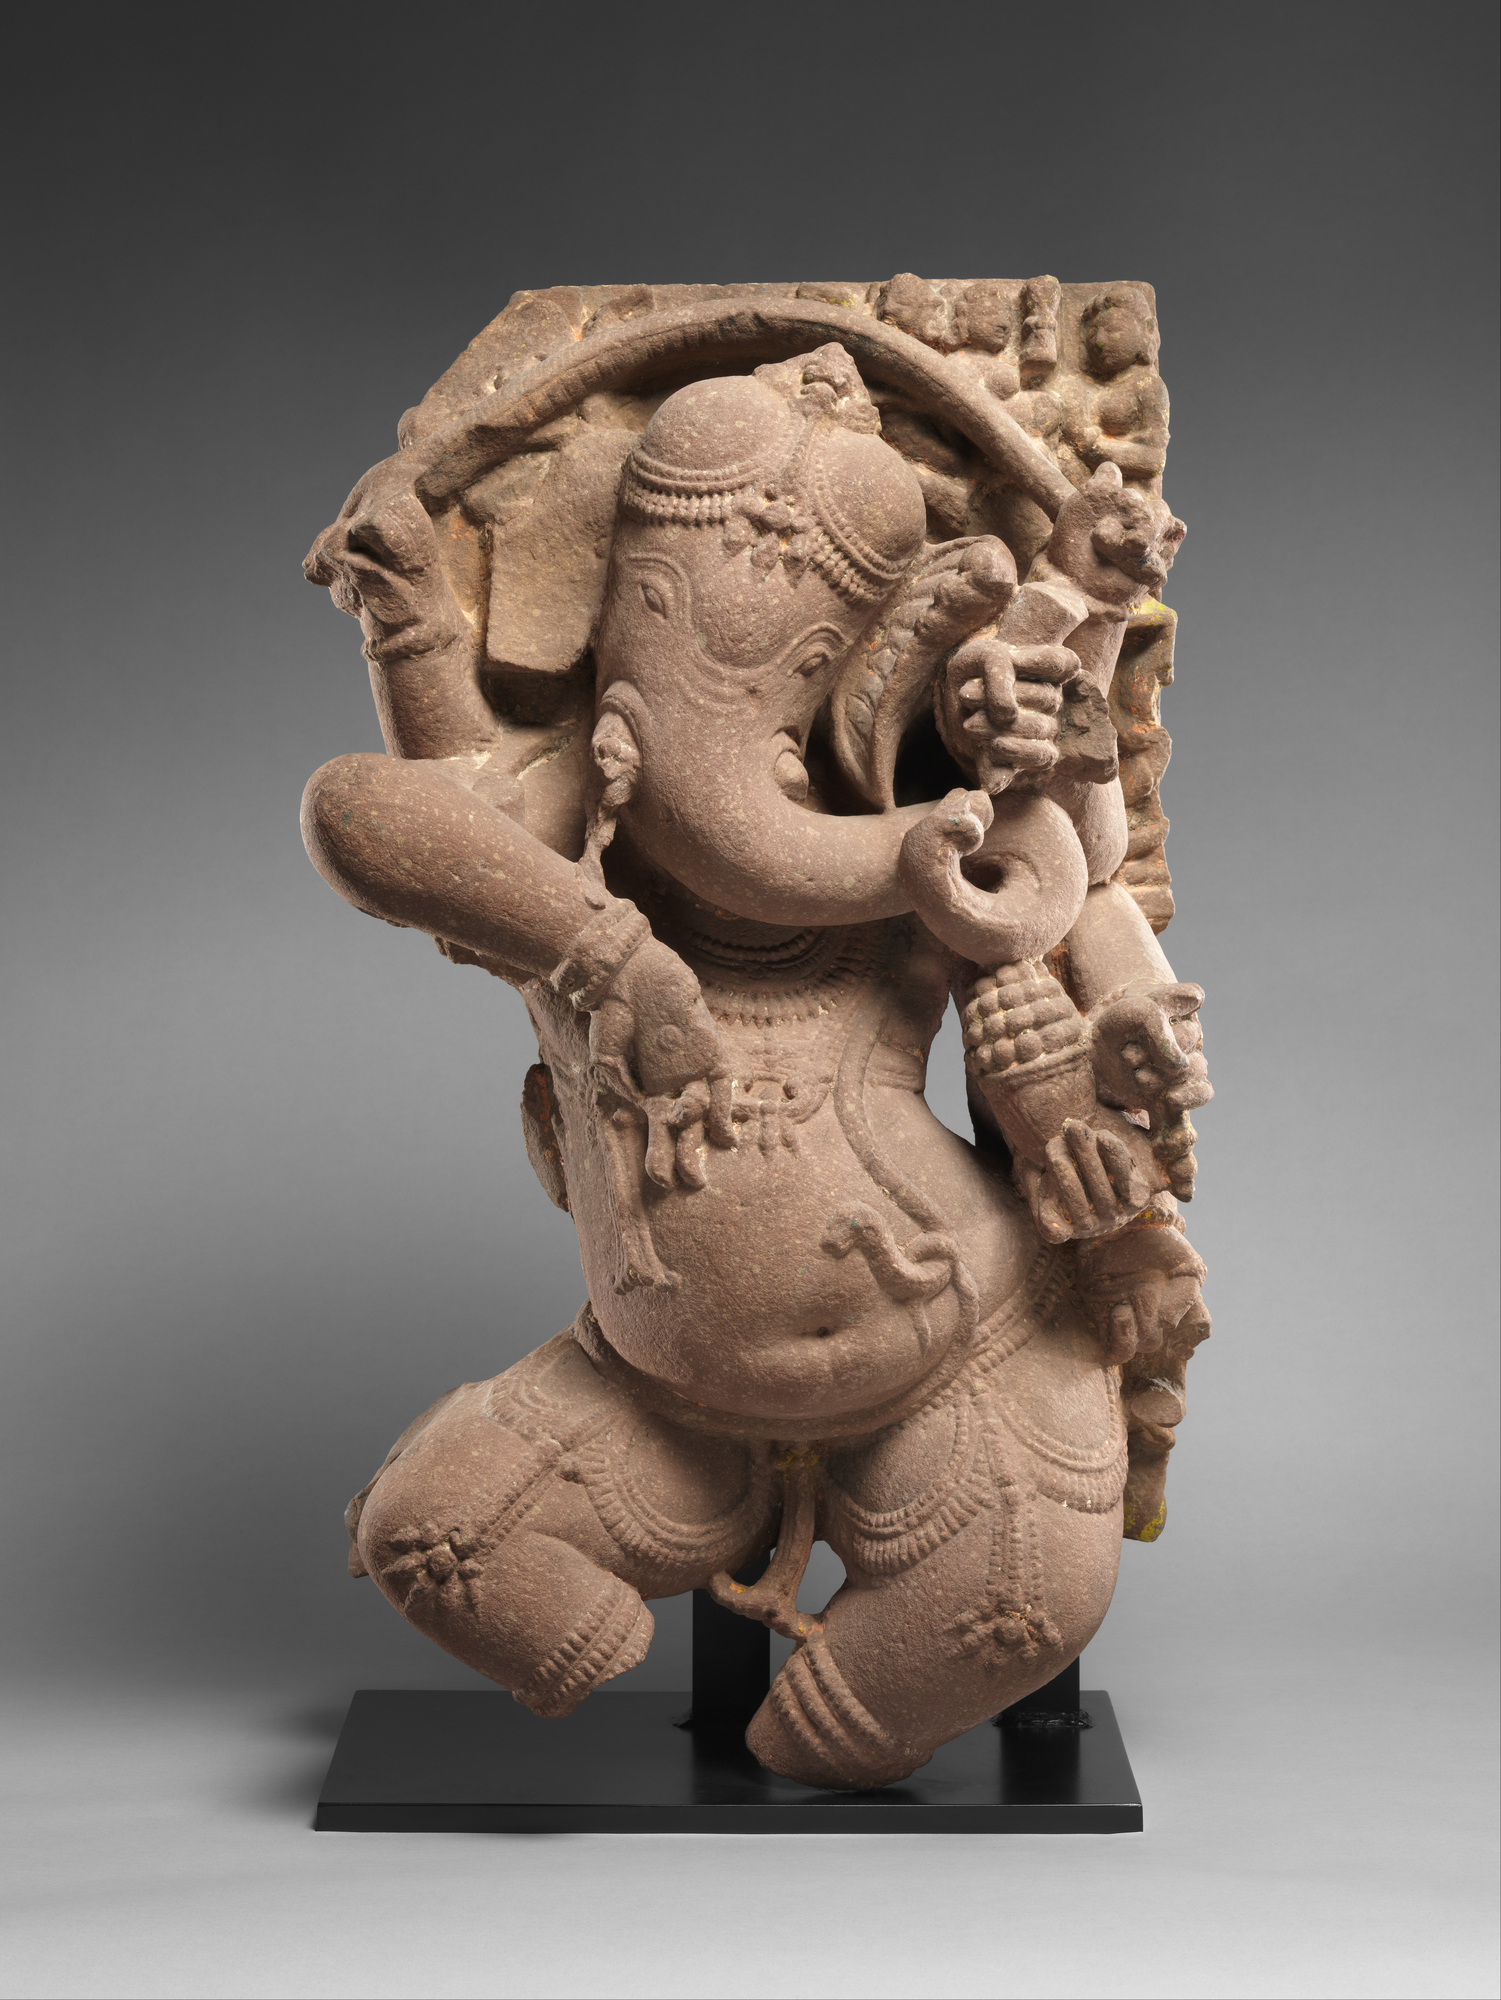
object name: figure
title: Dancing Ganesha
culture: indian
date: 901-1000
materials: stone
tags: dancing,ganesha